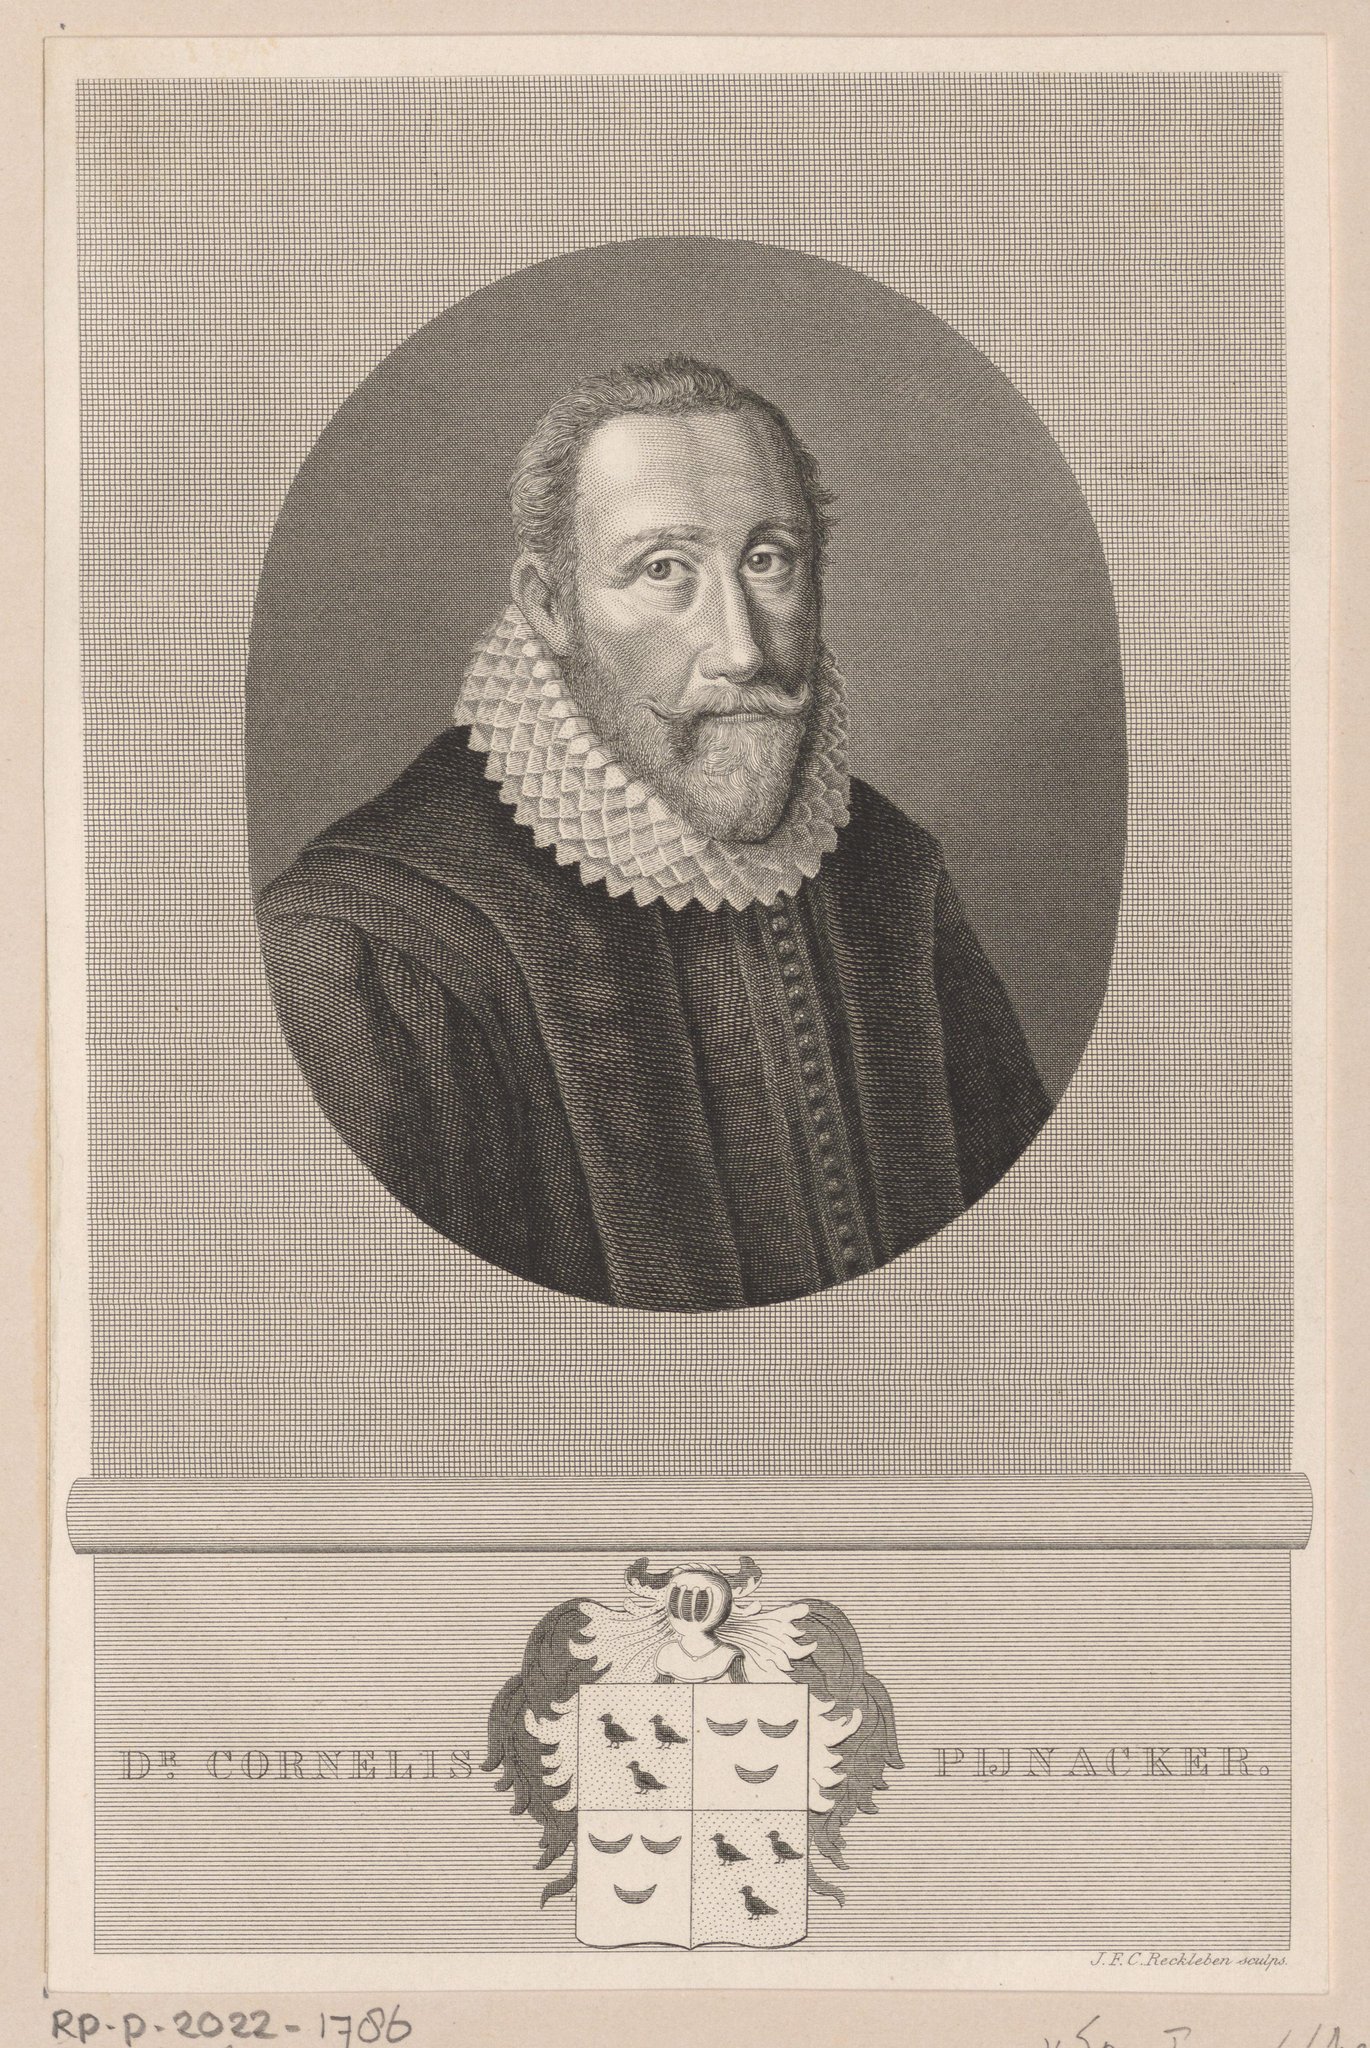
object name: print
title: Portret van Cornelis Pijnacker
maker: jan frederik christiaan reckleben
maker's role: print maker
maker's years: 1819-1879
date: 1858-1860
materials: paper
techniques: printmaking, letterpress printing, engraving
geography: amsterdam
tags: cornelis pijnacker, historical persons, professor, map making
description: Prent waarschijnlijk uit: Arend, Johannes Pieter. Algemeene geschiedenis des vaderlands van de vroegste tijden tot op heden. Amsterdam: J.F. Schleijer, 1840-1884, dl. 3.3, p. 726.